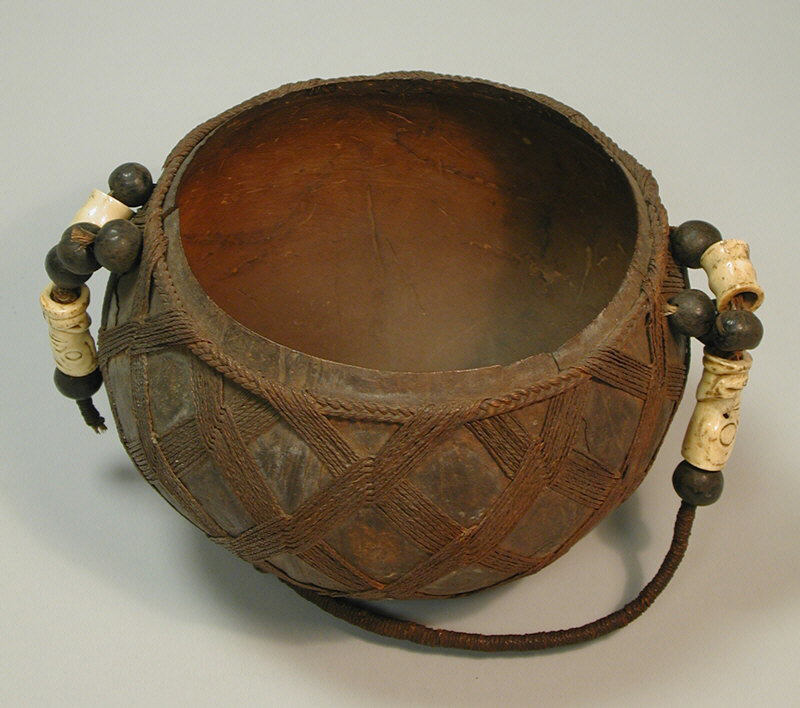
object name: bowl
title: Suspended Bowl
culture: marquesan, enata people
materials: bone, plant material, fiber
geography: marquesas islands